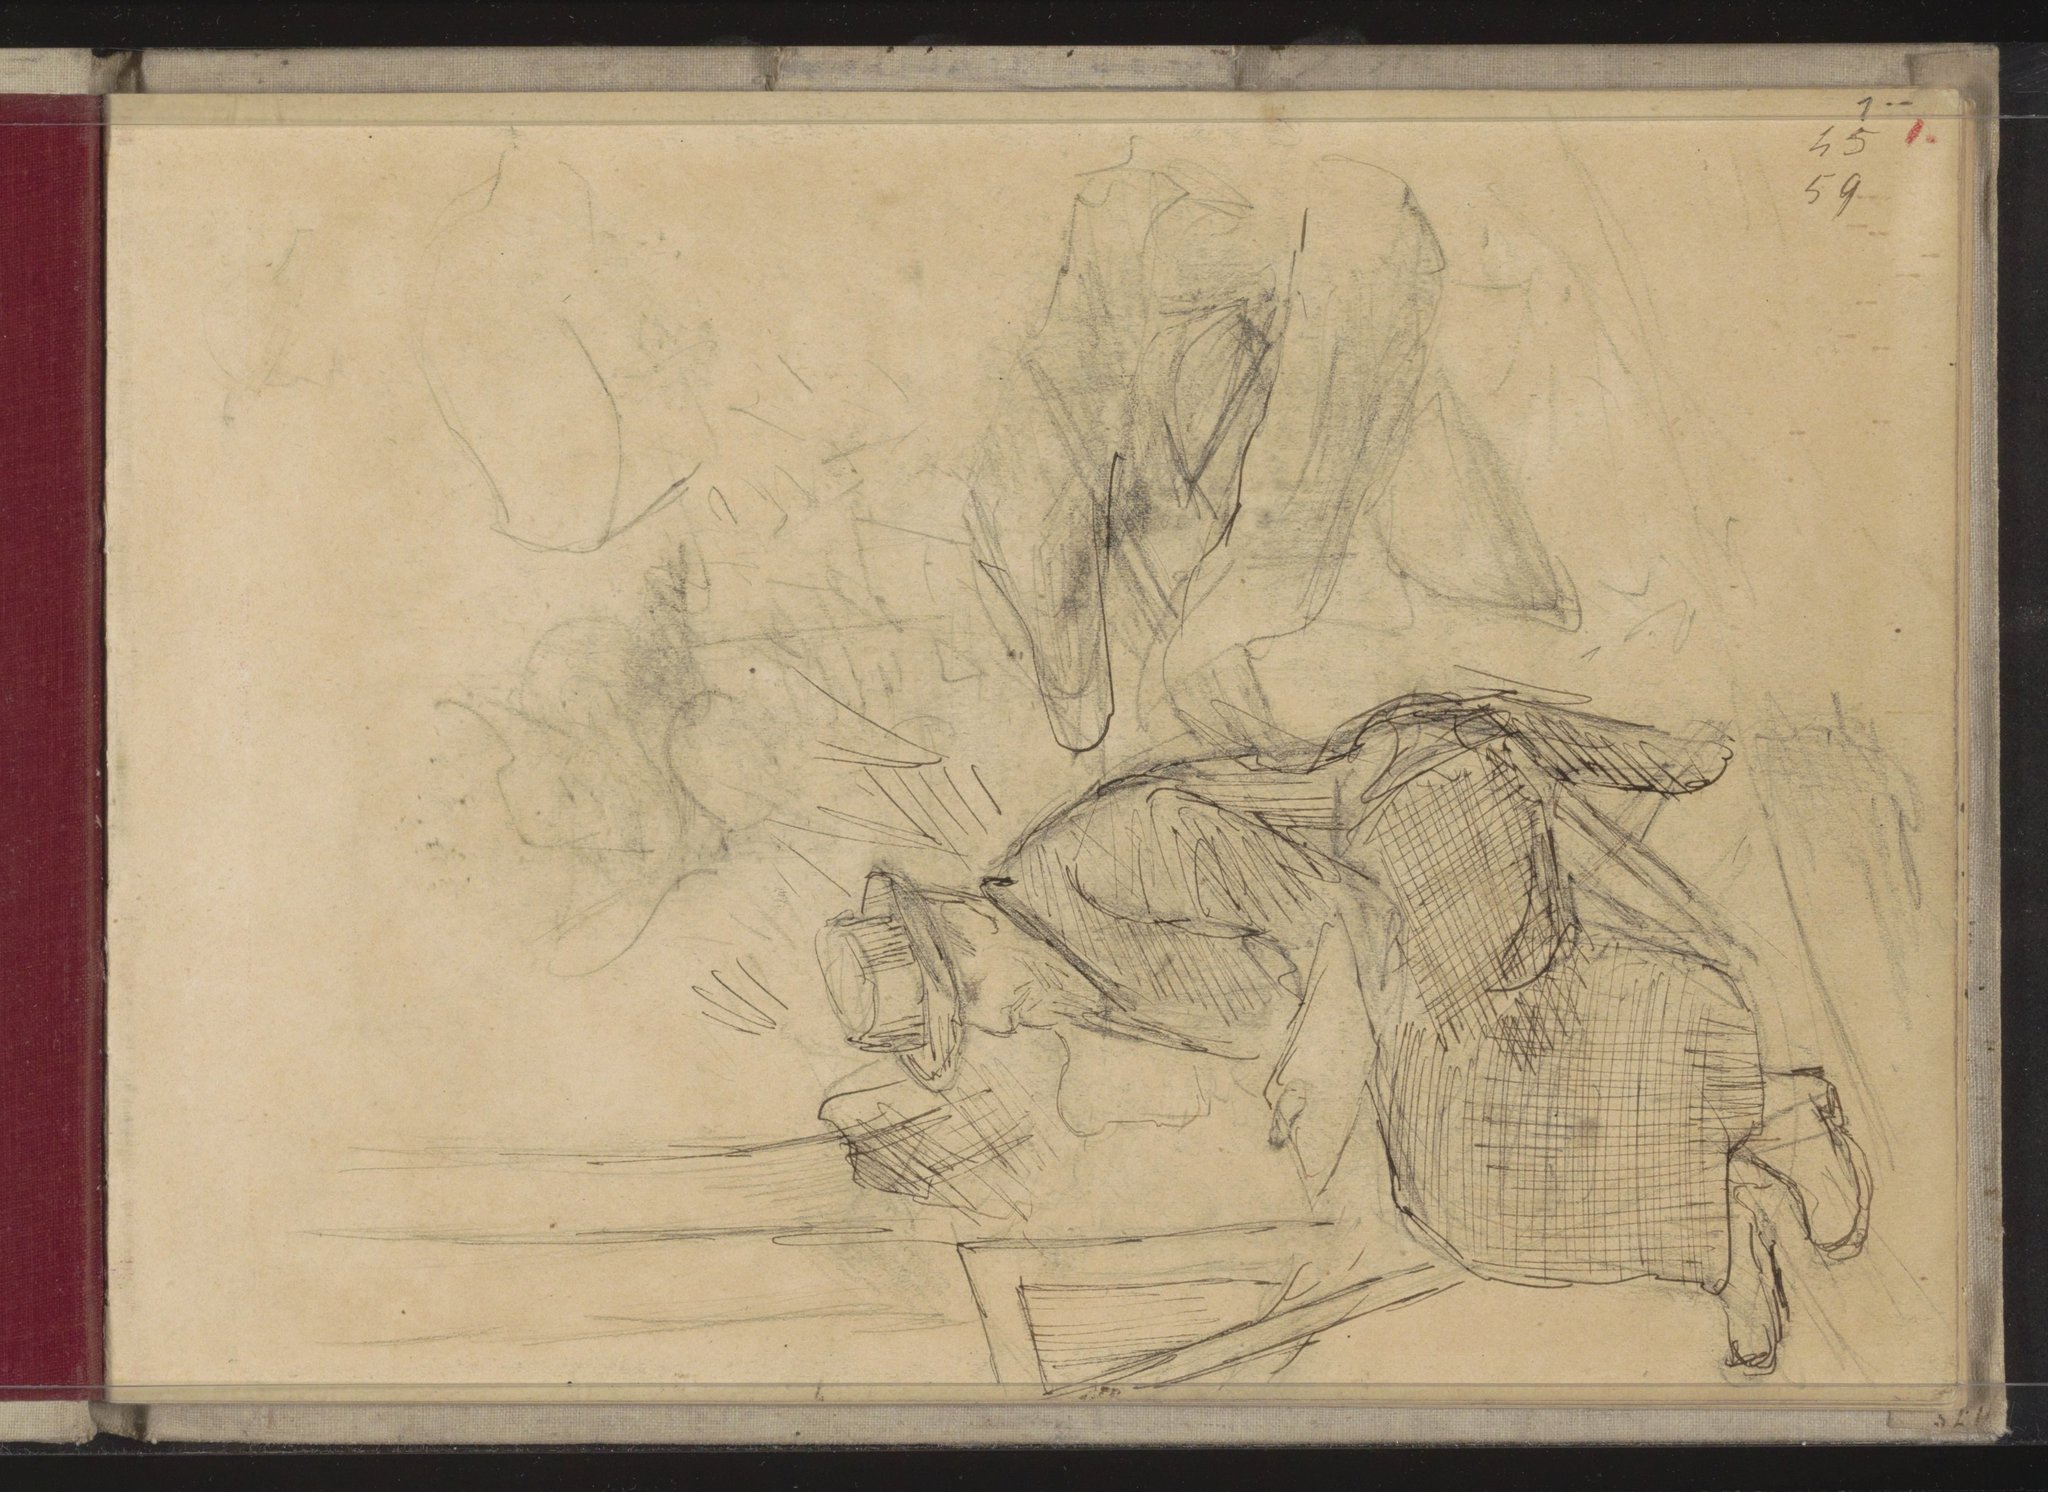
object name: sketchbook leaf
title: Kunstenaar zittend achter een ezel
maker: jozef israëls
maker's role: draughtsman, painter, print maker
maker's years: 1824-1911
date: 1834-1911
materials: ink, paper, pencil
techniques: pen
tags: artist at work, in his workshop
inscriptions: annotation: ‘55/ 59’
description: De man draagt een lange jas, hoed en heeft een palet in zijn linkerhand. Op de achtergrond is een deel van een interieur zichtbaar. Mogelijk een zelfportret. Blad 1 recto uit een schetsboek met 18 bladen.